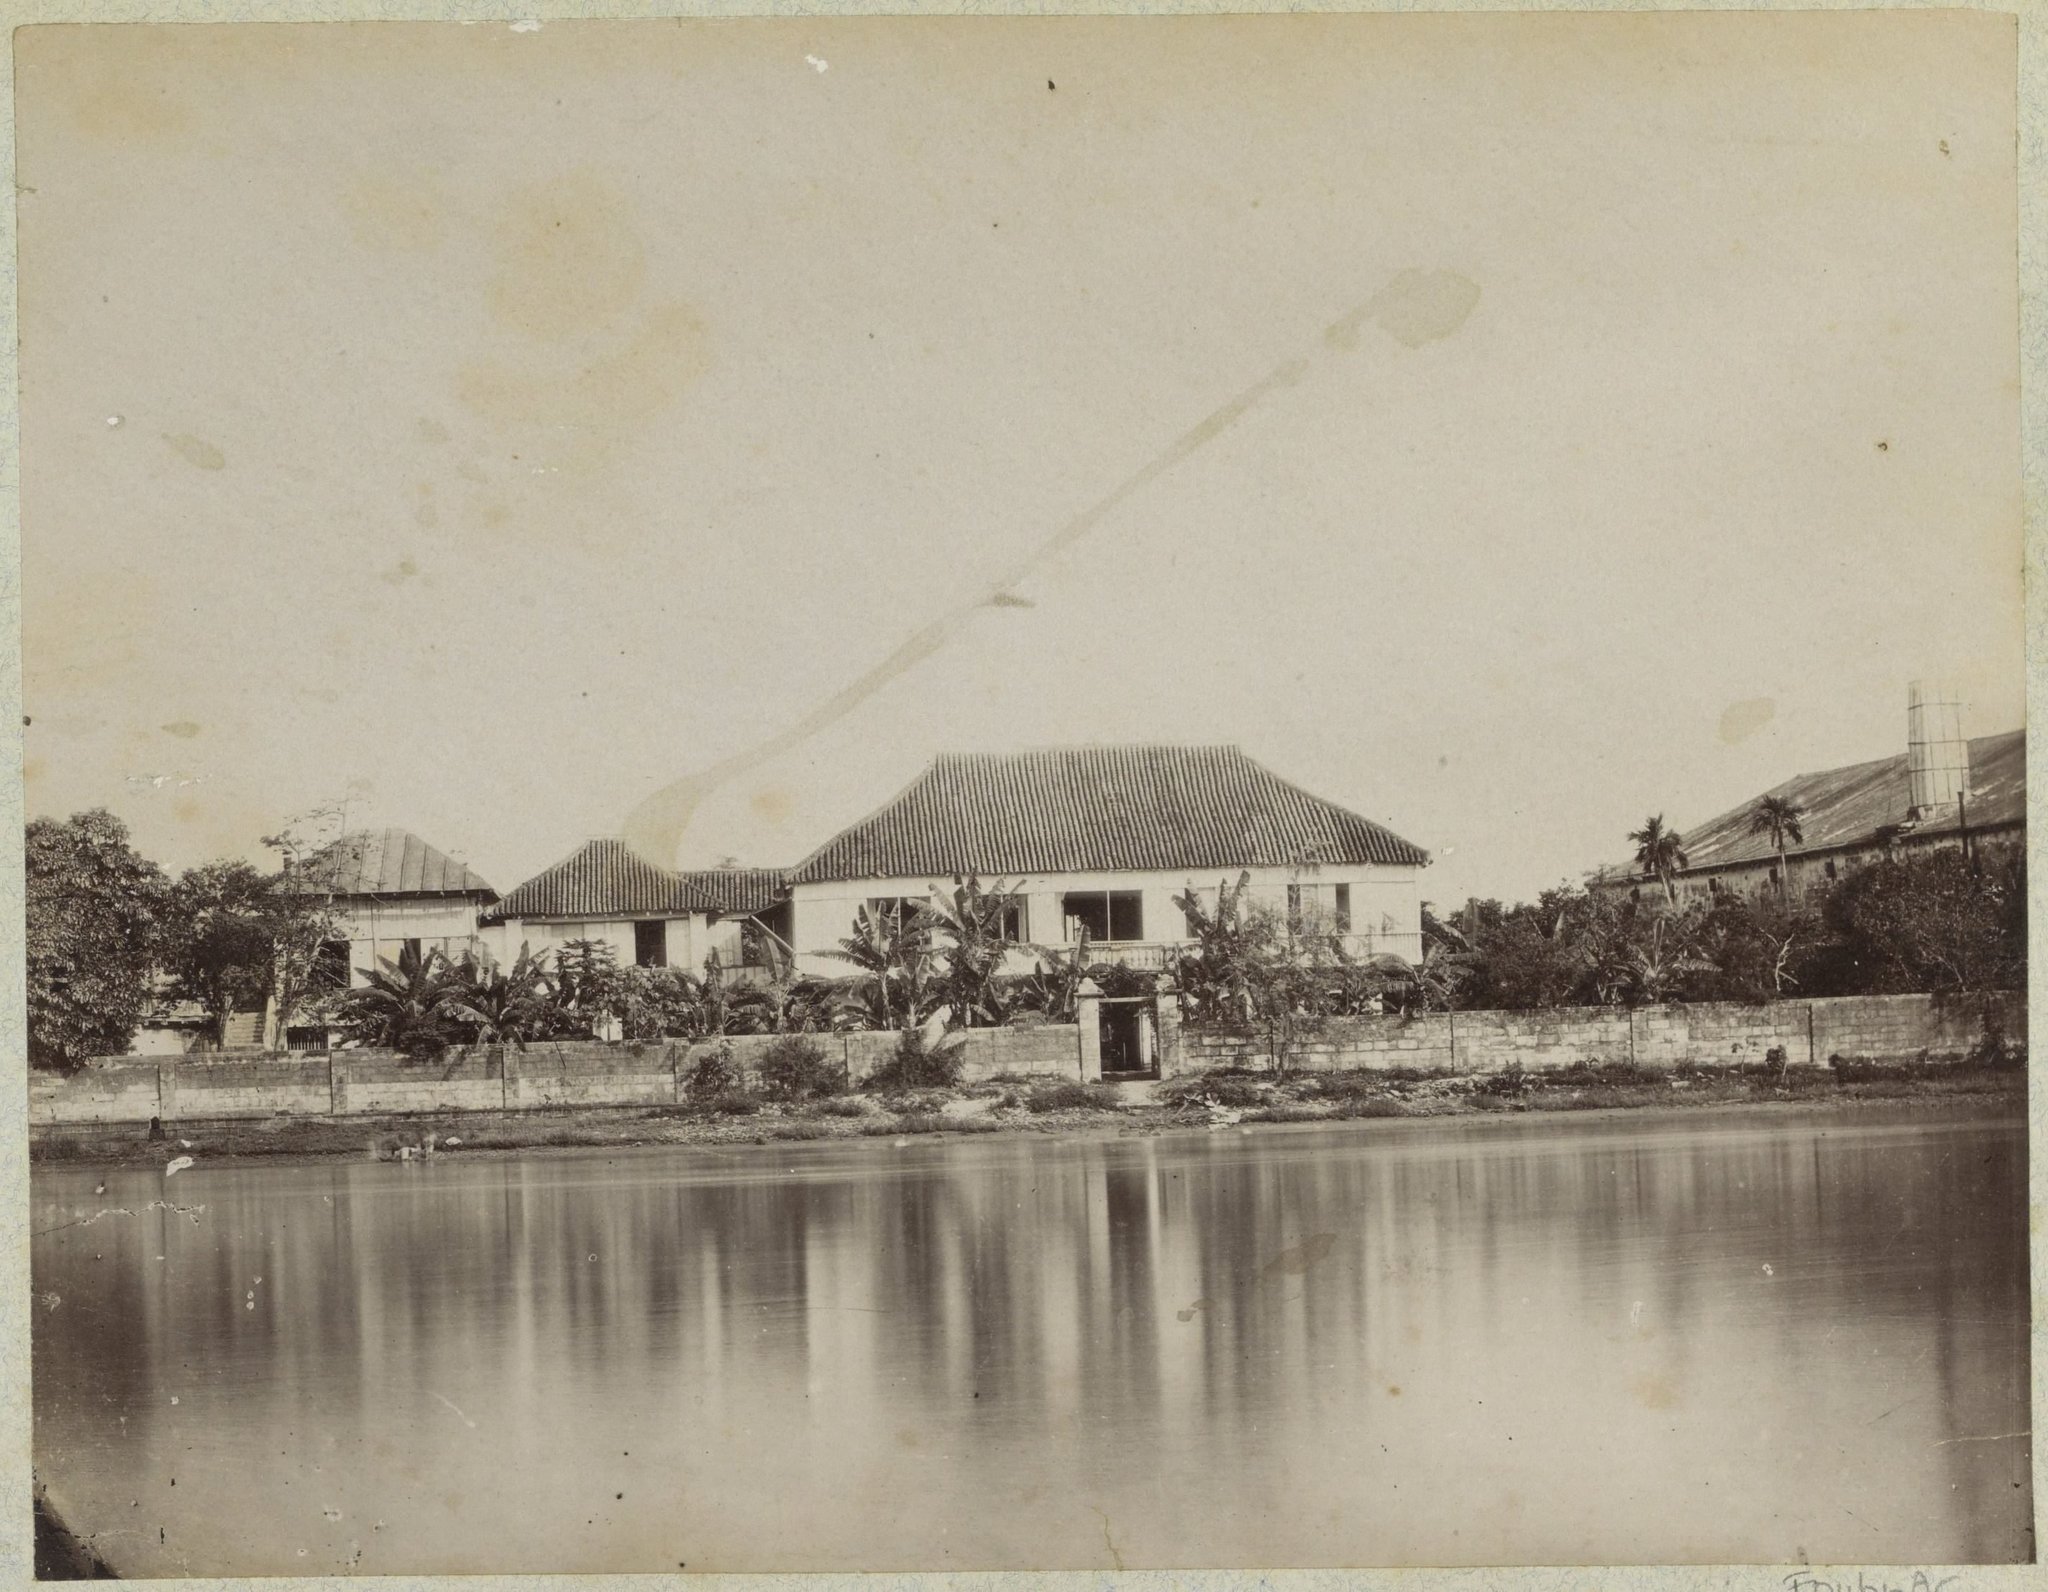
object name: photograph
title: Huis aan een meer, vermoedelijk op de Filipijnen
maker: Anonymous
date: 1870-1891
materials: paper, photographic support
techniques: albumen print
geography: philippines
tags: rural housing, e.g. country-house, villa, cottage, lake, philippines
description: Onderdeel van Fotoalbum van een reis naar Manilla.